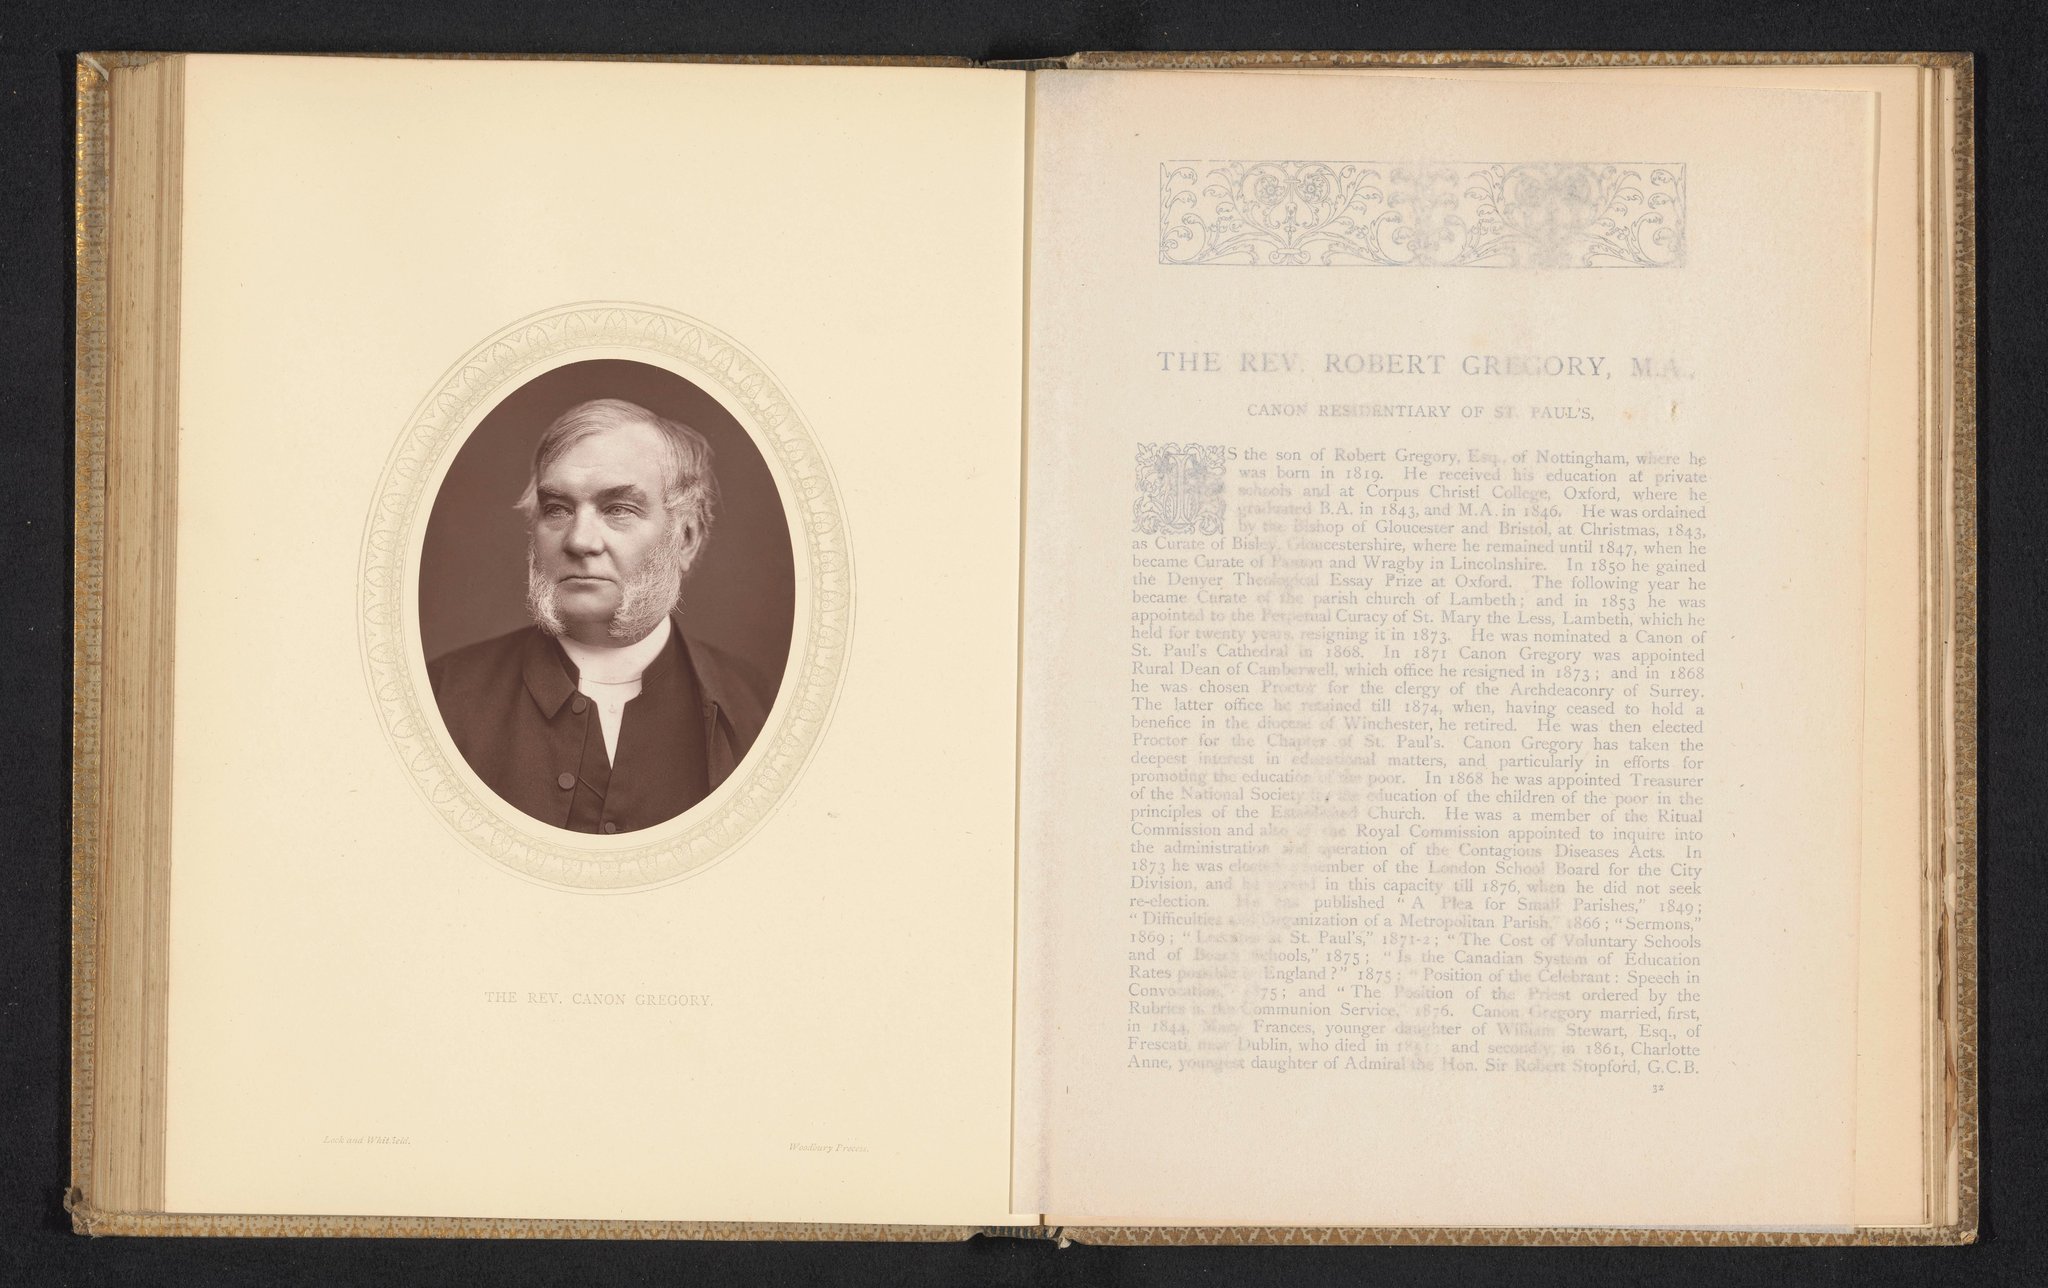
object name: photomechanical print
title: The rev. Canon Gregory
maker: Anonymous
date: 1871-1876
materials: paper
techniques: woodburytype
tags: priest (roman catholic), historical persons (portraits and scenes from the life) (+ (full) bust portrait)